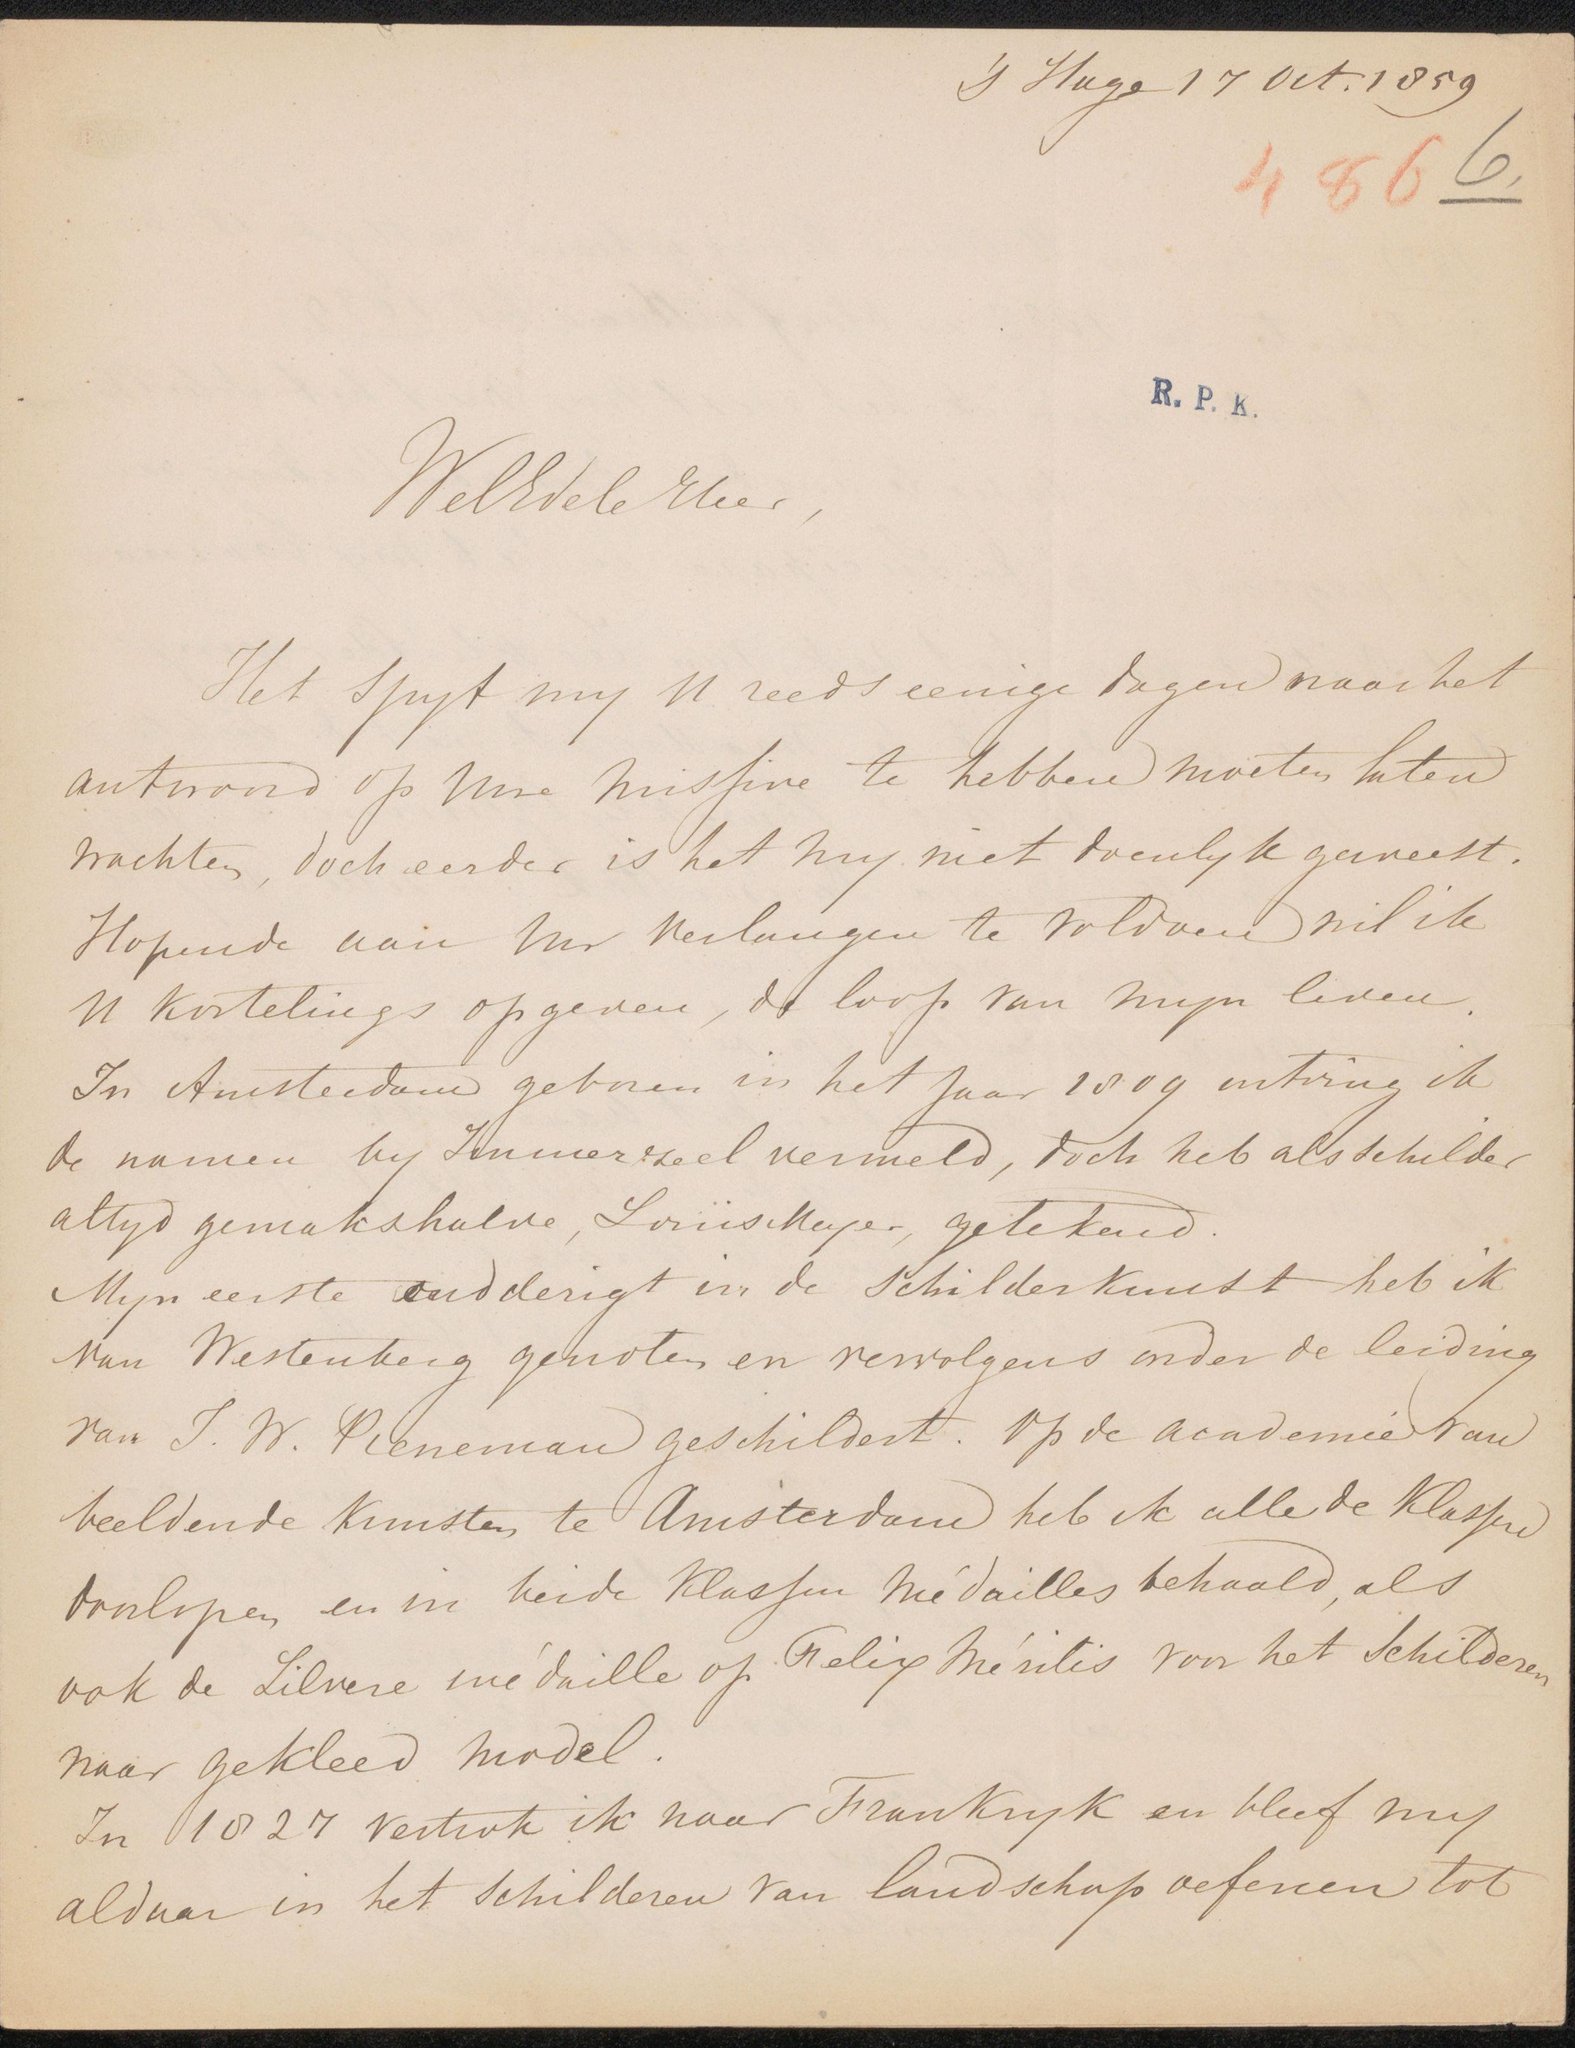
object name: letter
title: Brief aan Christiaan Kramm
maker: louis meijer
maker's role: draughtsman, painter, print maker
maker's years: 1809-1866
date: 1859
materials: ink, paper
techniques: pen, writing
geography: the hague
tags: jan willem pieneman, nijmegen, painter, draughtsman, george pieter westenberg, utrecht, print maker, christiaan kramm, distribution of awards ~ art contest, family life, education, tuition of the artist (in general), painting (including book-illumination, miniature-painting), art collecting, france, deventer, paris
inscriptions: collector's mark: Lugt 2233